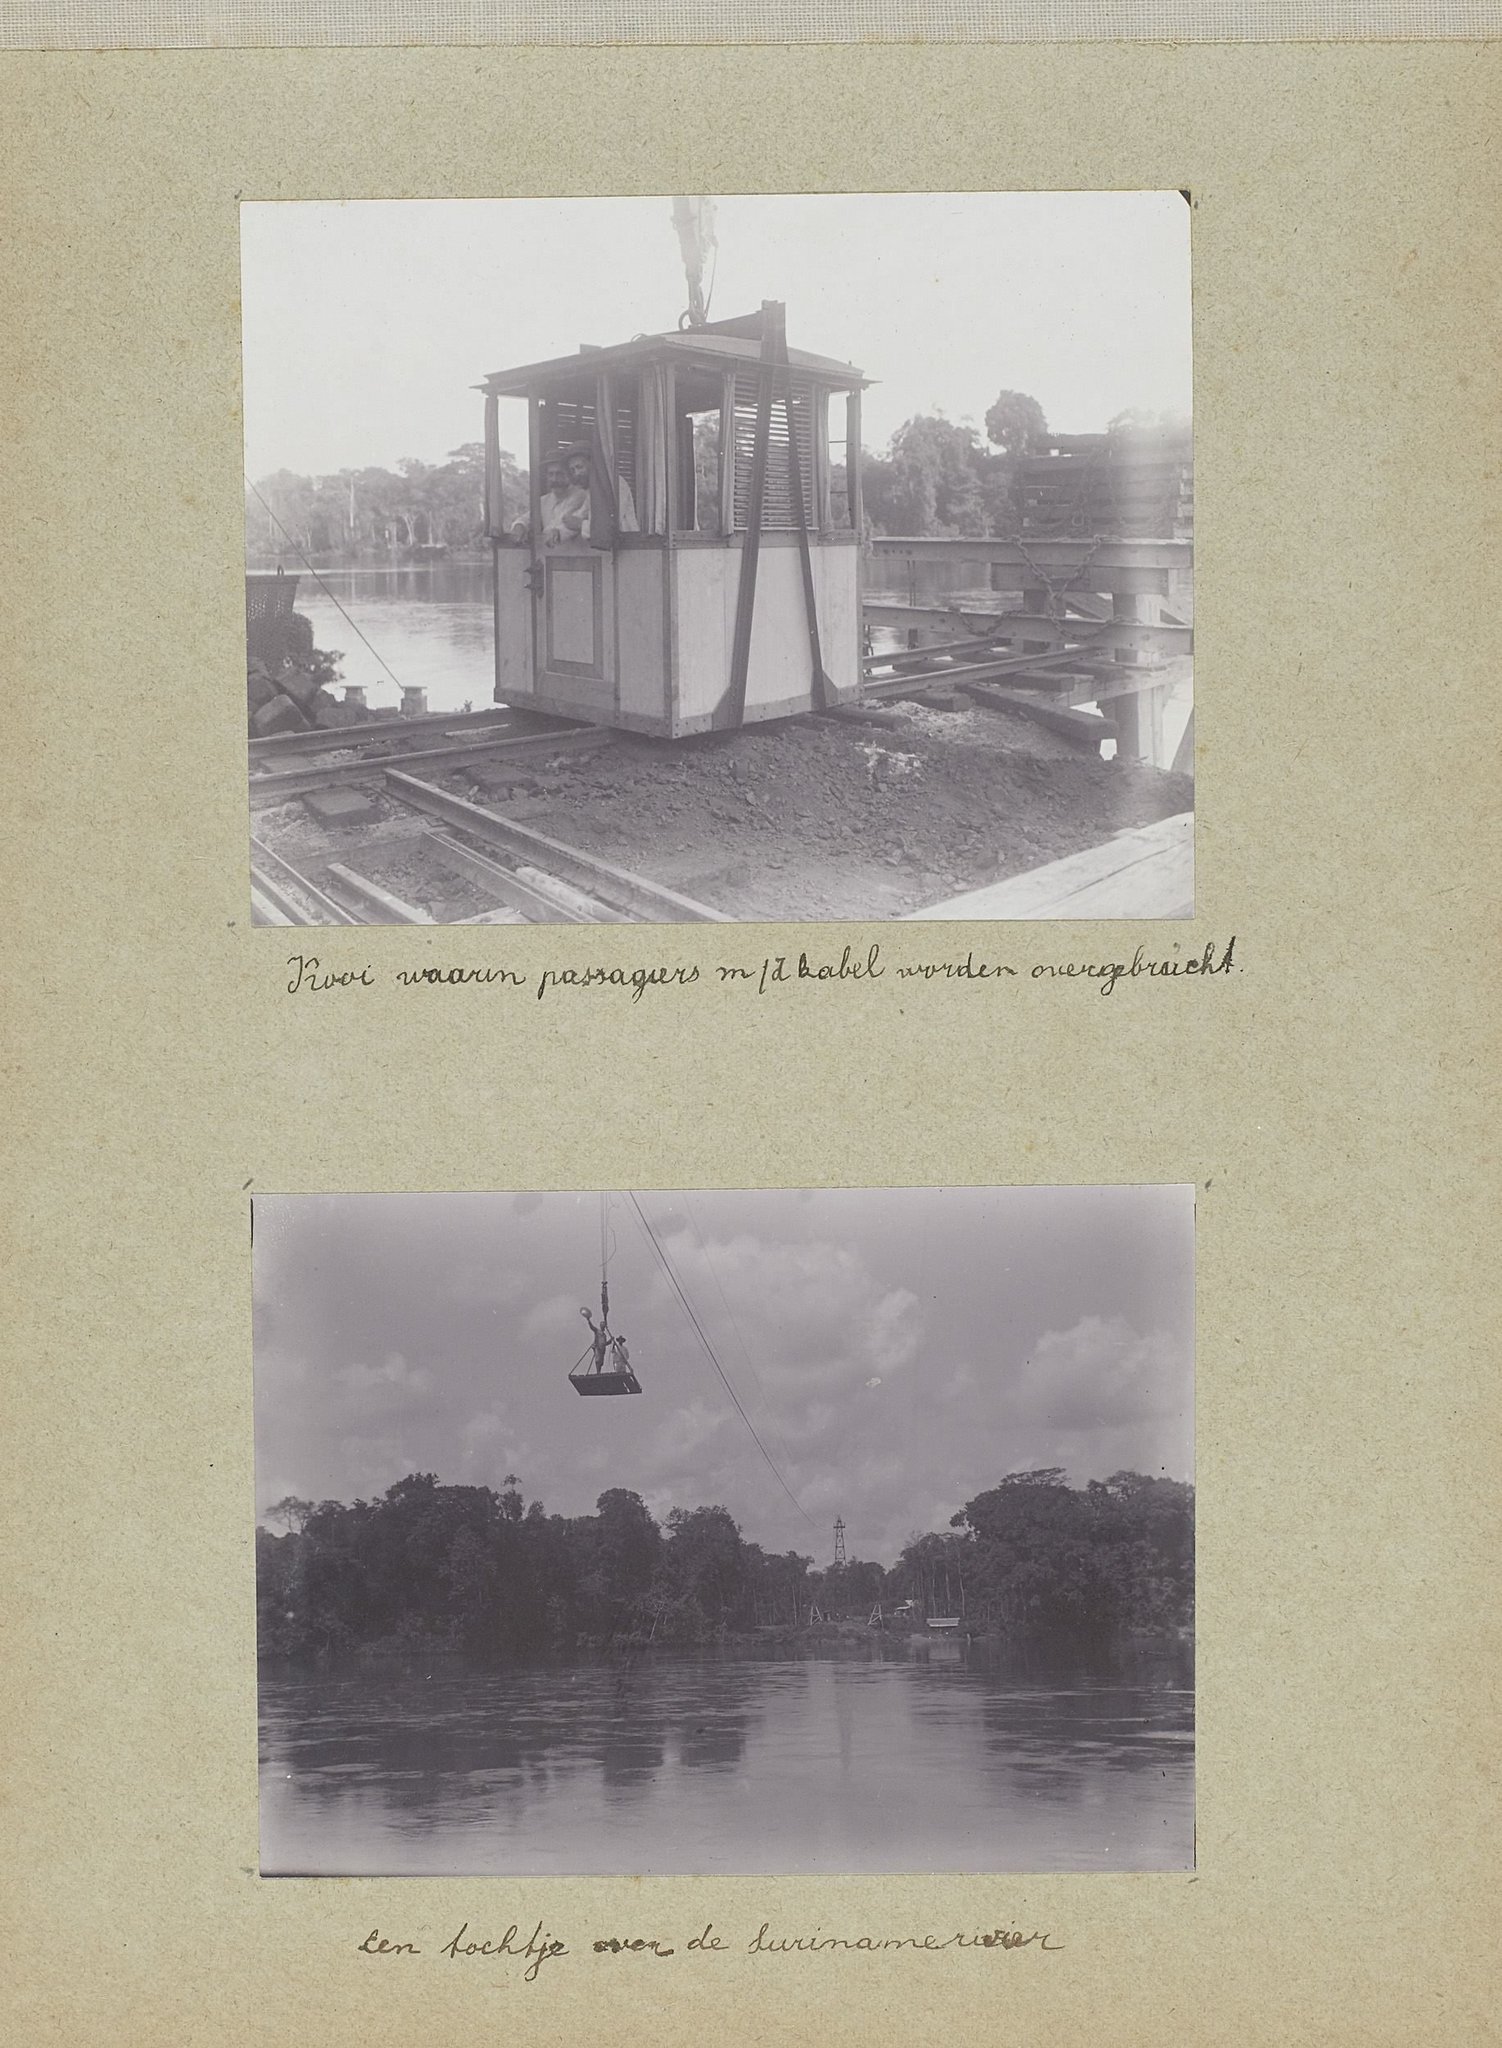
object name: photograph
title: Kooi waarin passagiers m/d kabel worden overgebracht / Een tochtje over de Surinamerivier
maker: Anonymous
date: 1905-1910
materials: photographic support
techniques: photography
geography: suriname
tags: jacob evert wesenhagen, railway, tramway; rack railway, suriname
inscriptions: inscription: ‘Kooi waarin passagiers m/d kabel worden overgebracht / Een tochtje over de Surinamerivier’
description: Albumblad met twee foto's. Boven: de kooi waarin passagiers met de kabelbrug over de rivier gebracht kunnen worden. Onder: Twee mannen maken de oversteek met de kabelbrug. Foto's in het fotoalbum over de aanleg van de Lawaspoorweg in Suriname in de jaren 1903-1912. Onderdeel van een groep objecten afkomstig van de familie Wesenhagen in Suriname.